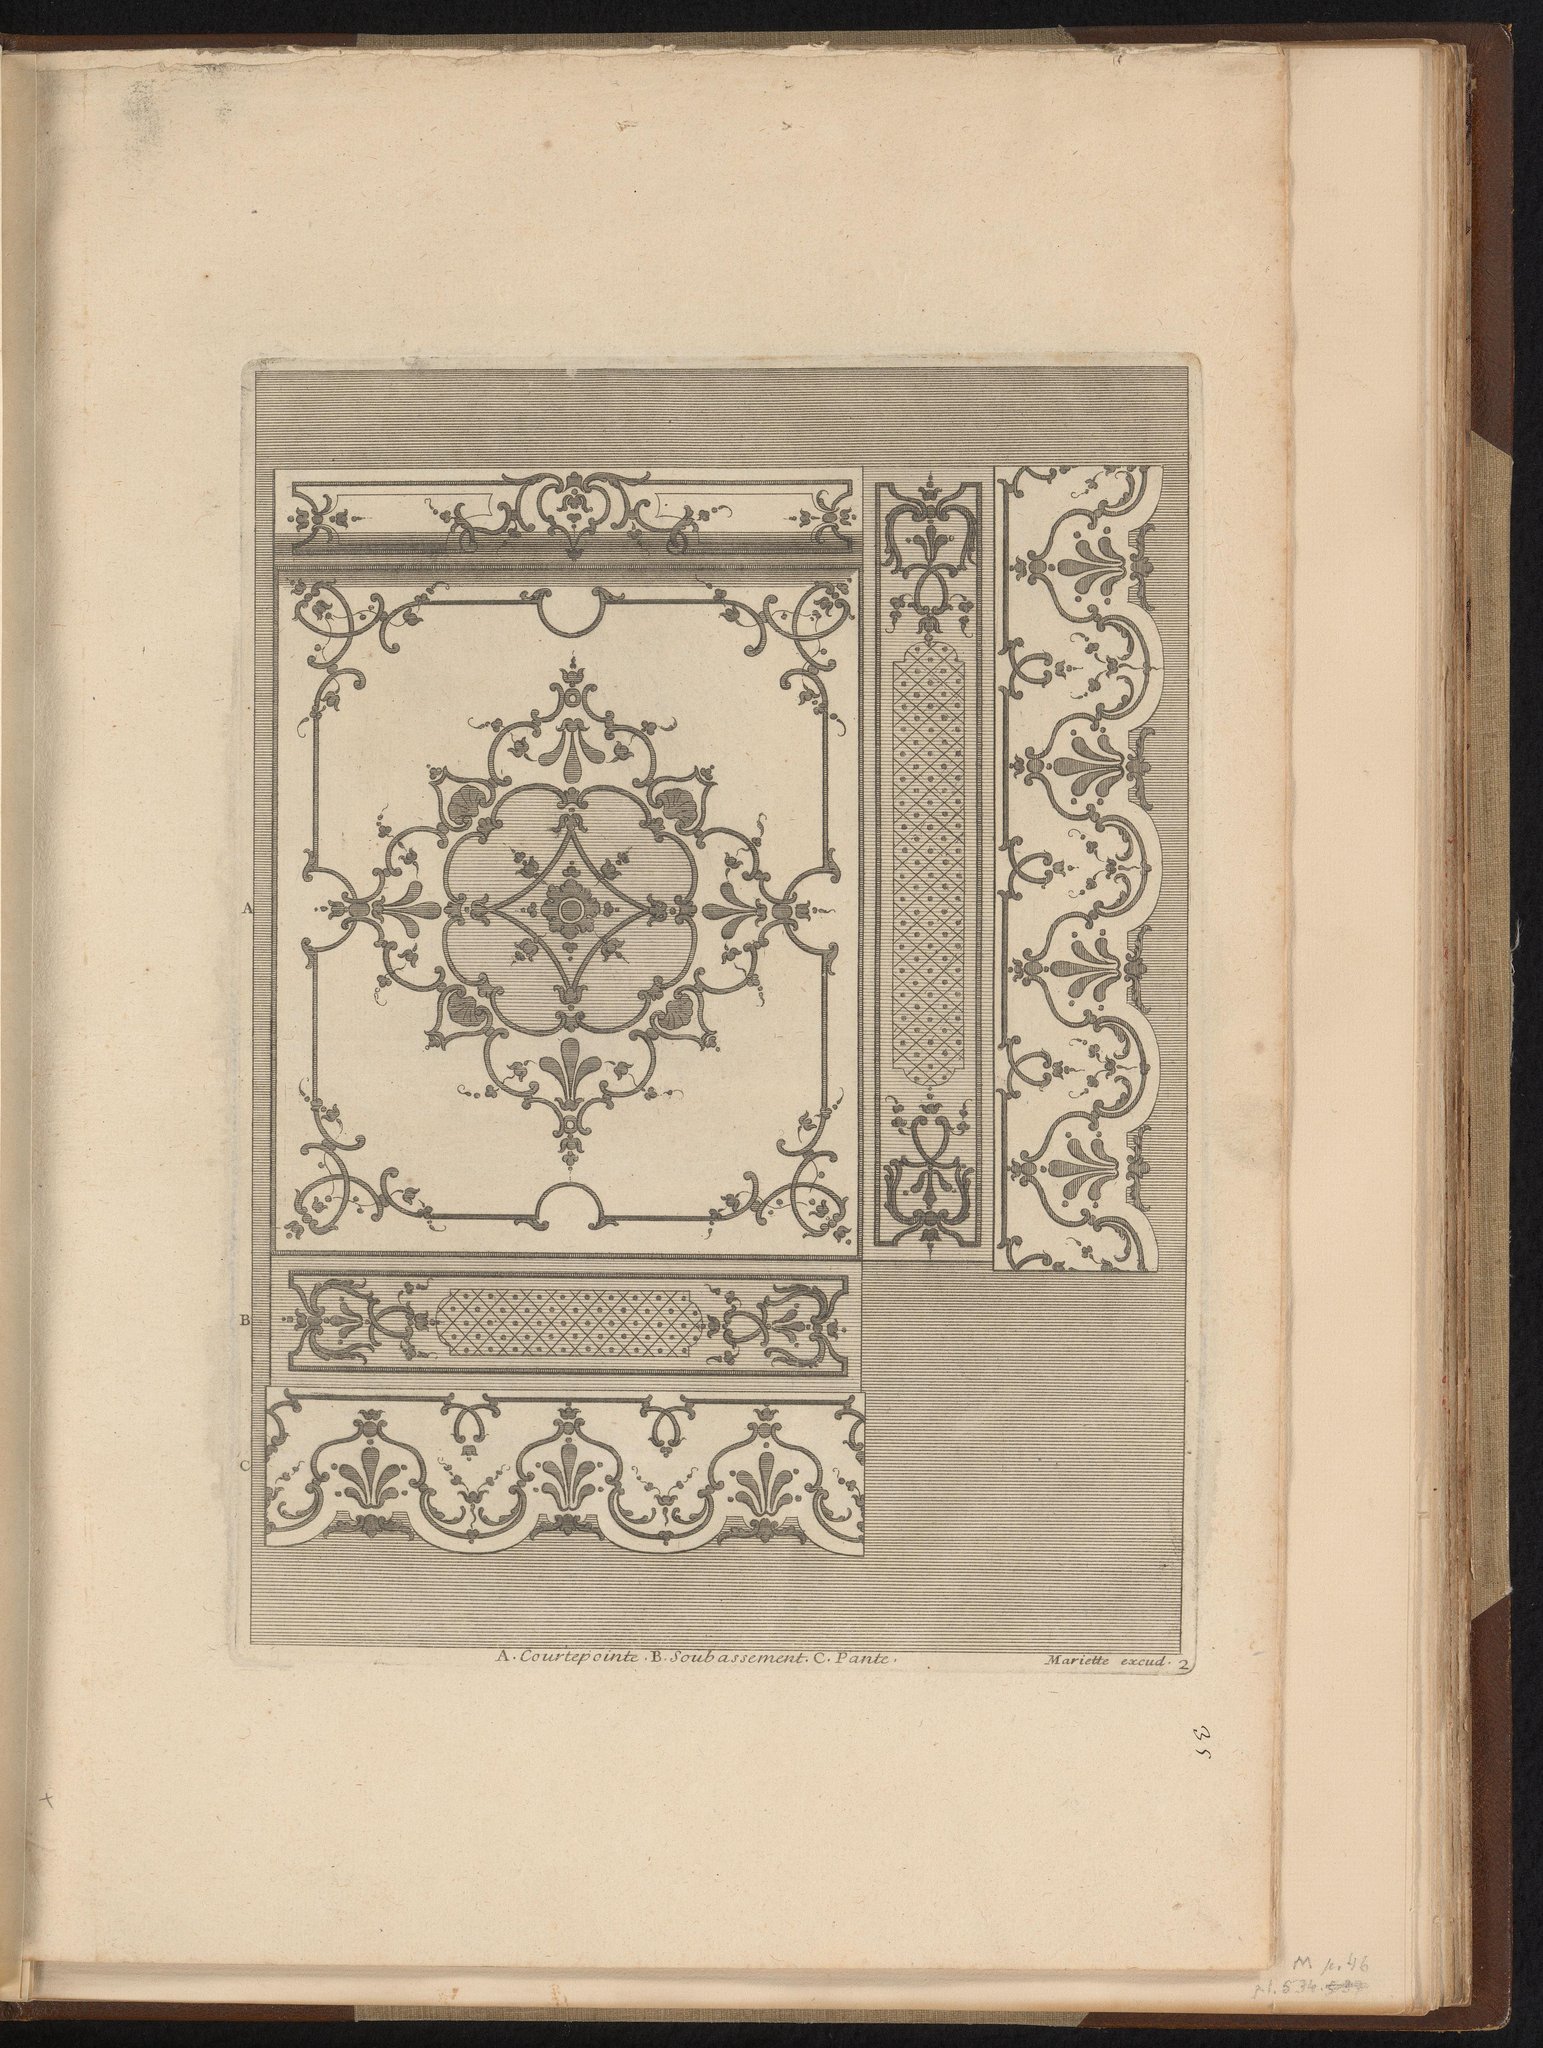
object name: print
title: Ontwerp voor panelen van een bed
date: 1725-1750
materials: paper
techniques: etching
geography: paris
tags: ornaments ~ art, bed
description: Deze prent maakt deel uit van een album.